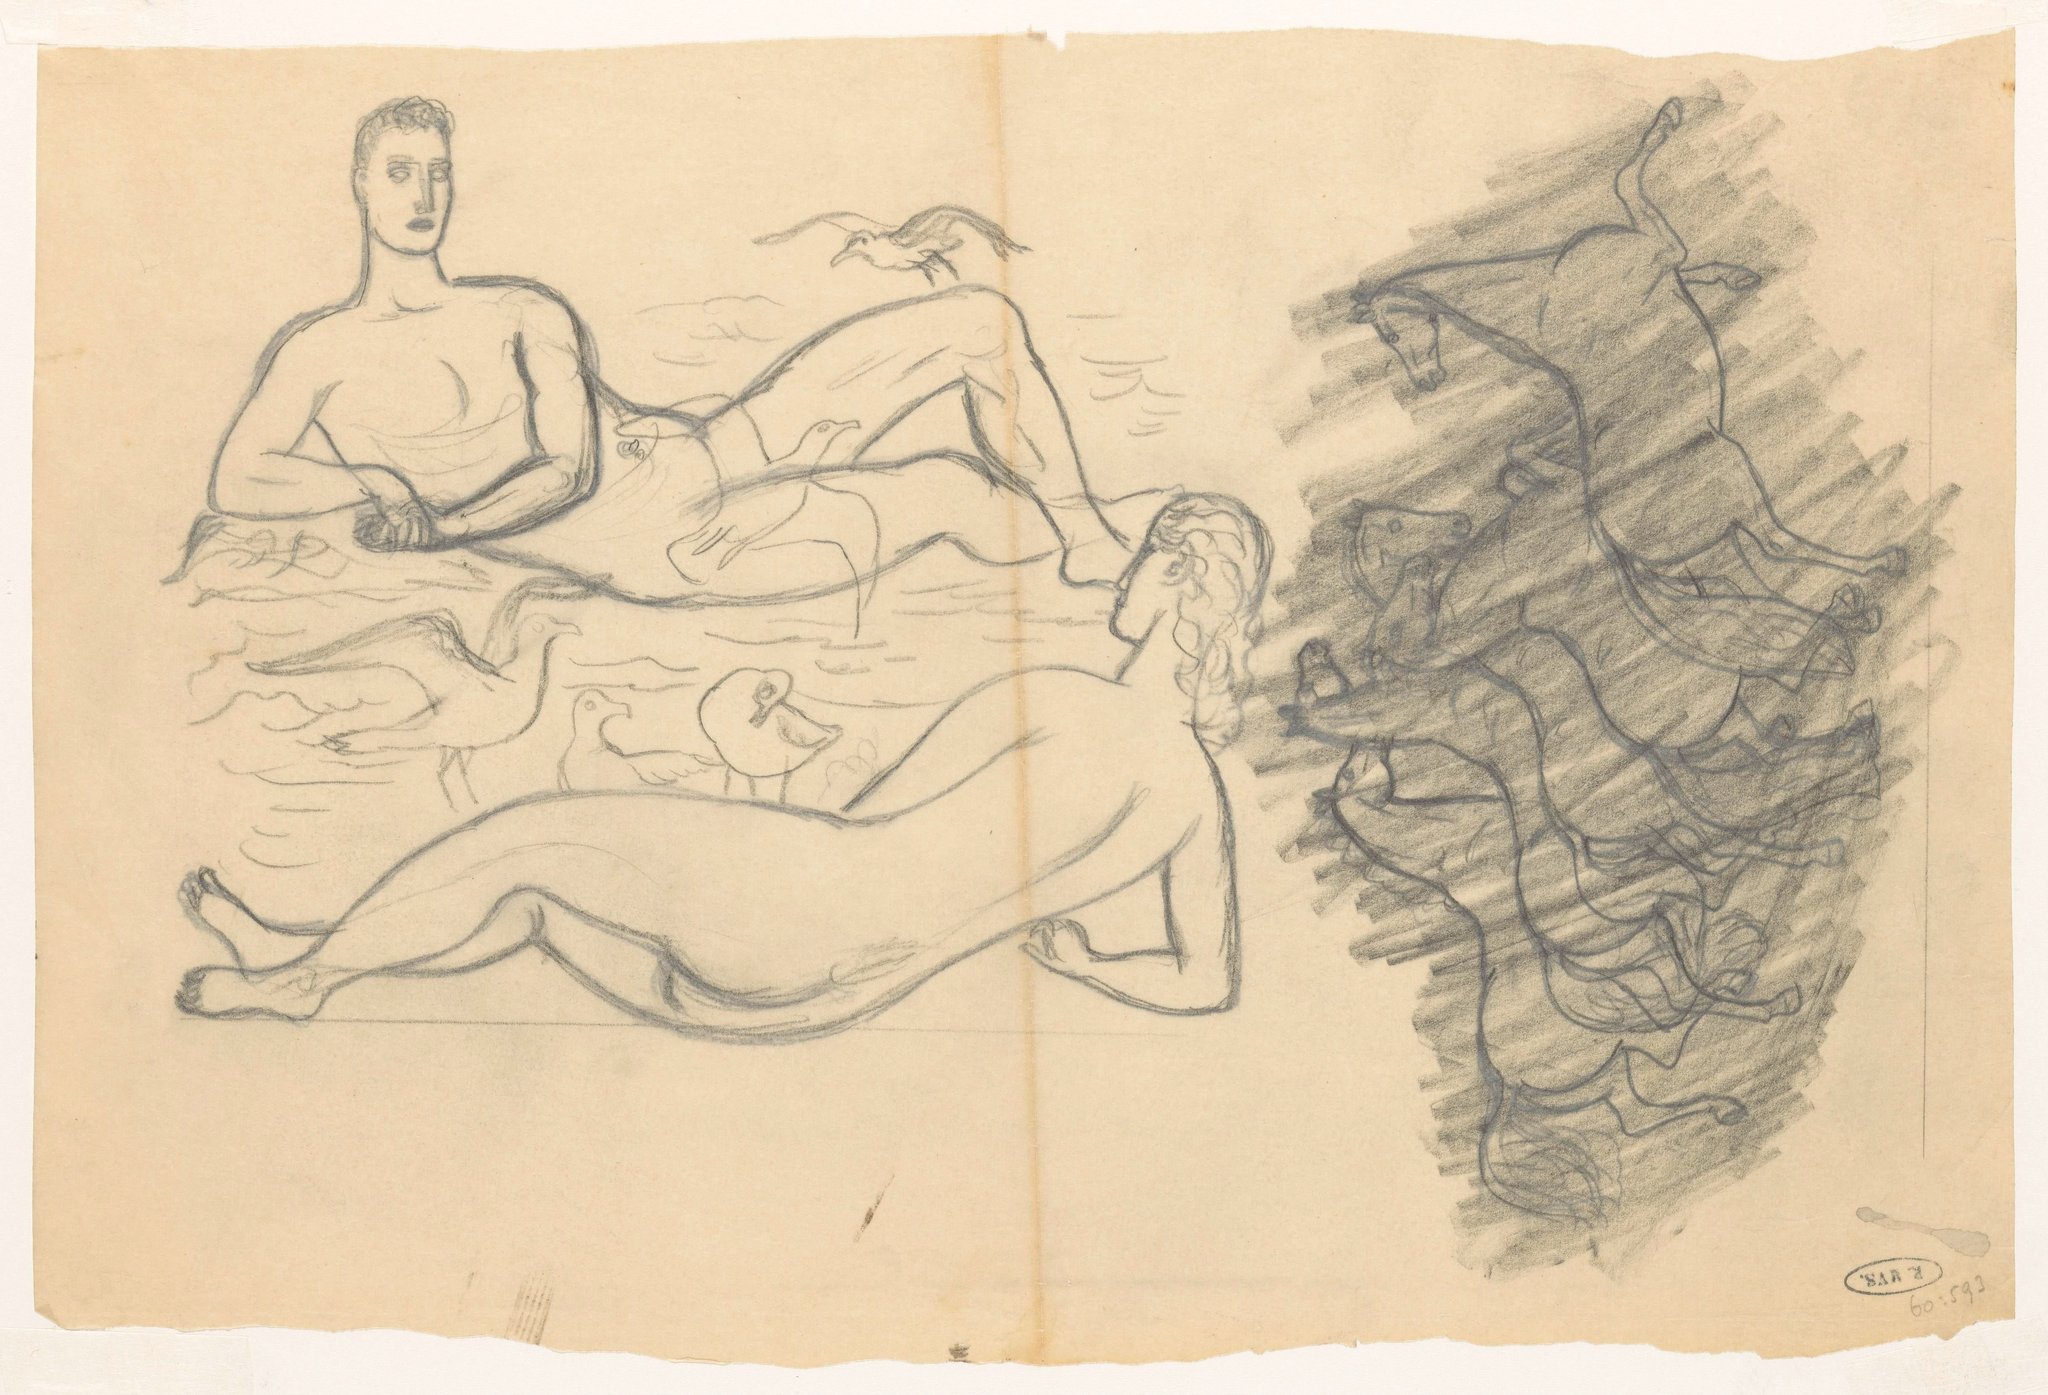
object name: drawing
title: Naakte man en vrouw aan het strand, omringd door zeemeeuwen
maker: leo gestel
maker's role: draughtsman, print maker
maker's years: 1881-1941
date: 1891-1941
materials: pencil, paper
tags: lying on one side, with uplifted upper part of the body and leaning on the arm - aa - female human figure (+ nude human being), lying on one side, with uplifted upper part of the body and leaning on the arm (+ nude human being), beach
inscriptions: collector's mark: Lugt 2228